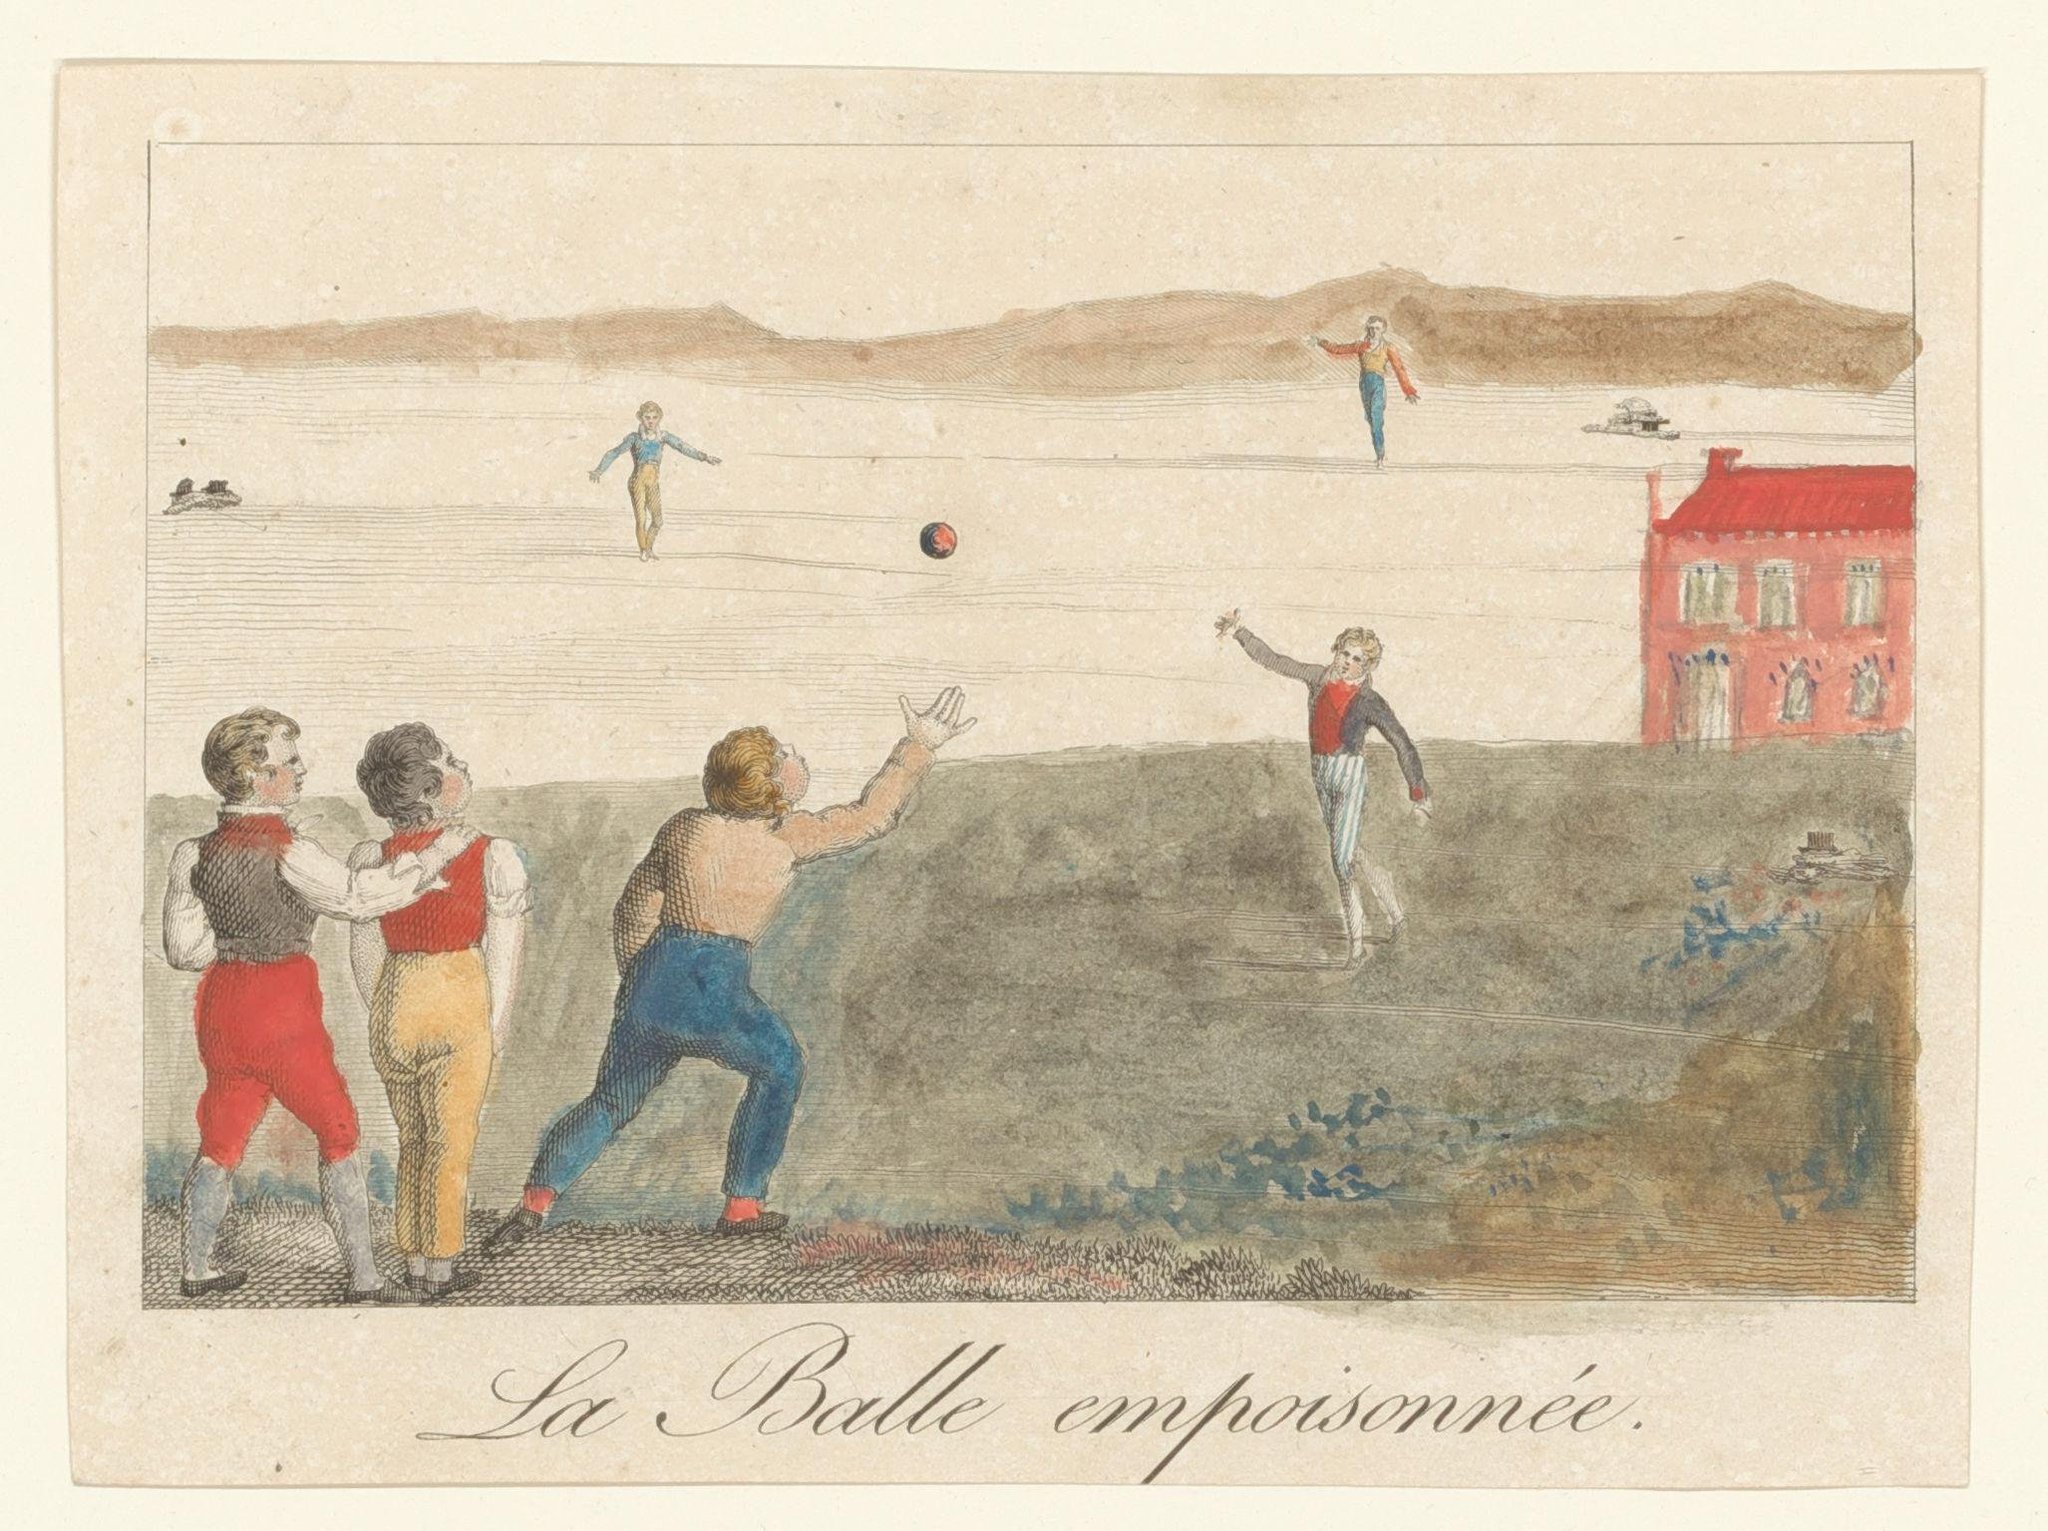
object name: print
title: La Balle empoisonnée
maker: Anonymous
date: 1800-1899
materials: paper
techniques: etching, hand coloring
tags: children's games and plays, throwing games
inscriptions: collector's mark: Lugt 1641, stamp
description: Onderwerpsrubrieken binnen de Atlas Zeden en Gewoonten: Zeden en Gewoonten in Engeren Zin, Des menschen beging, midden en einde, Kinderleven – Kinderspel en Kinderprenten.